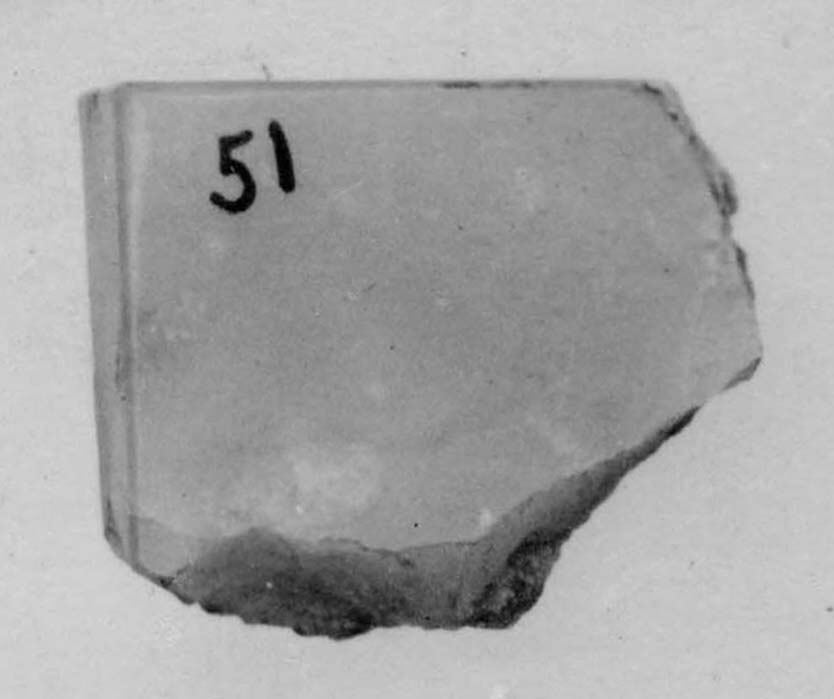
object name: fragment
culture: tibetan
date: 1902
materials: jade